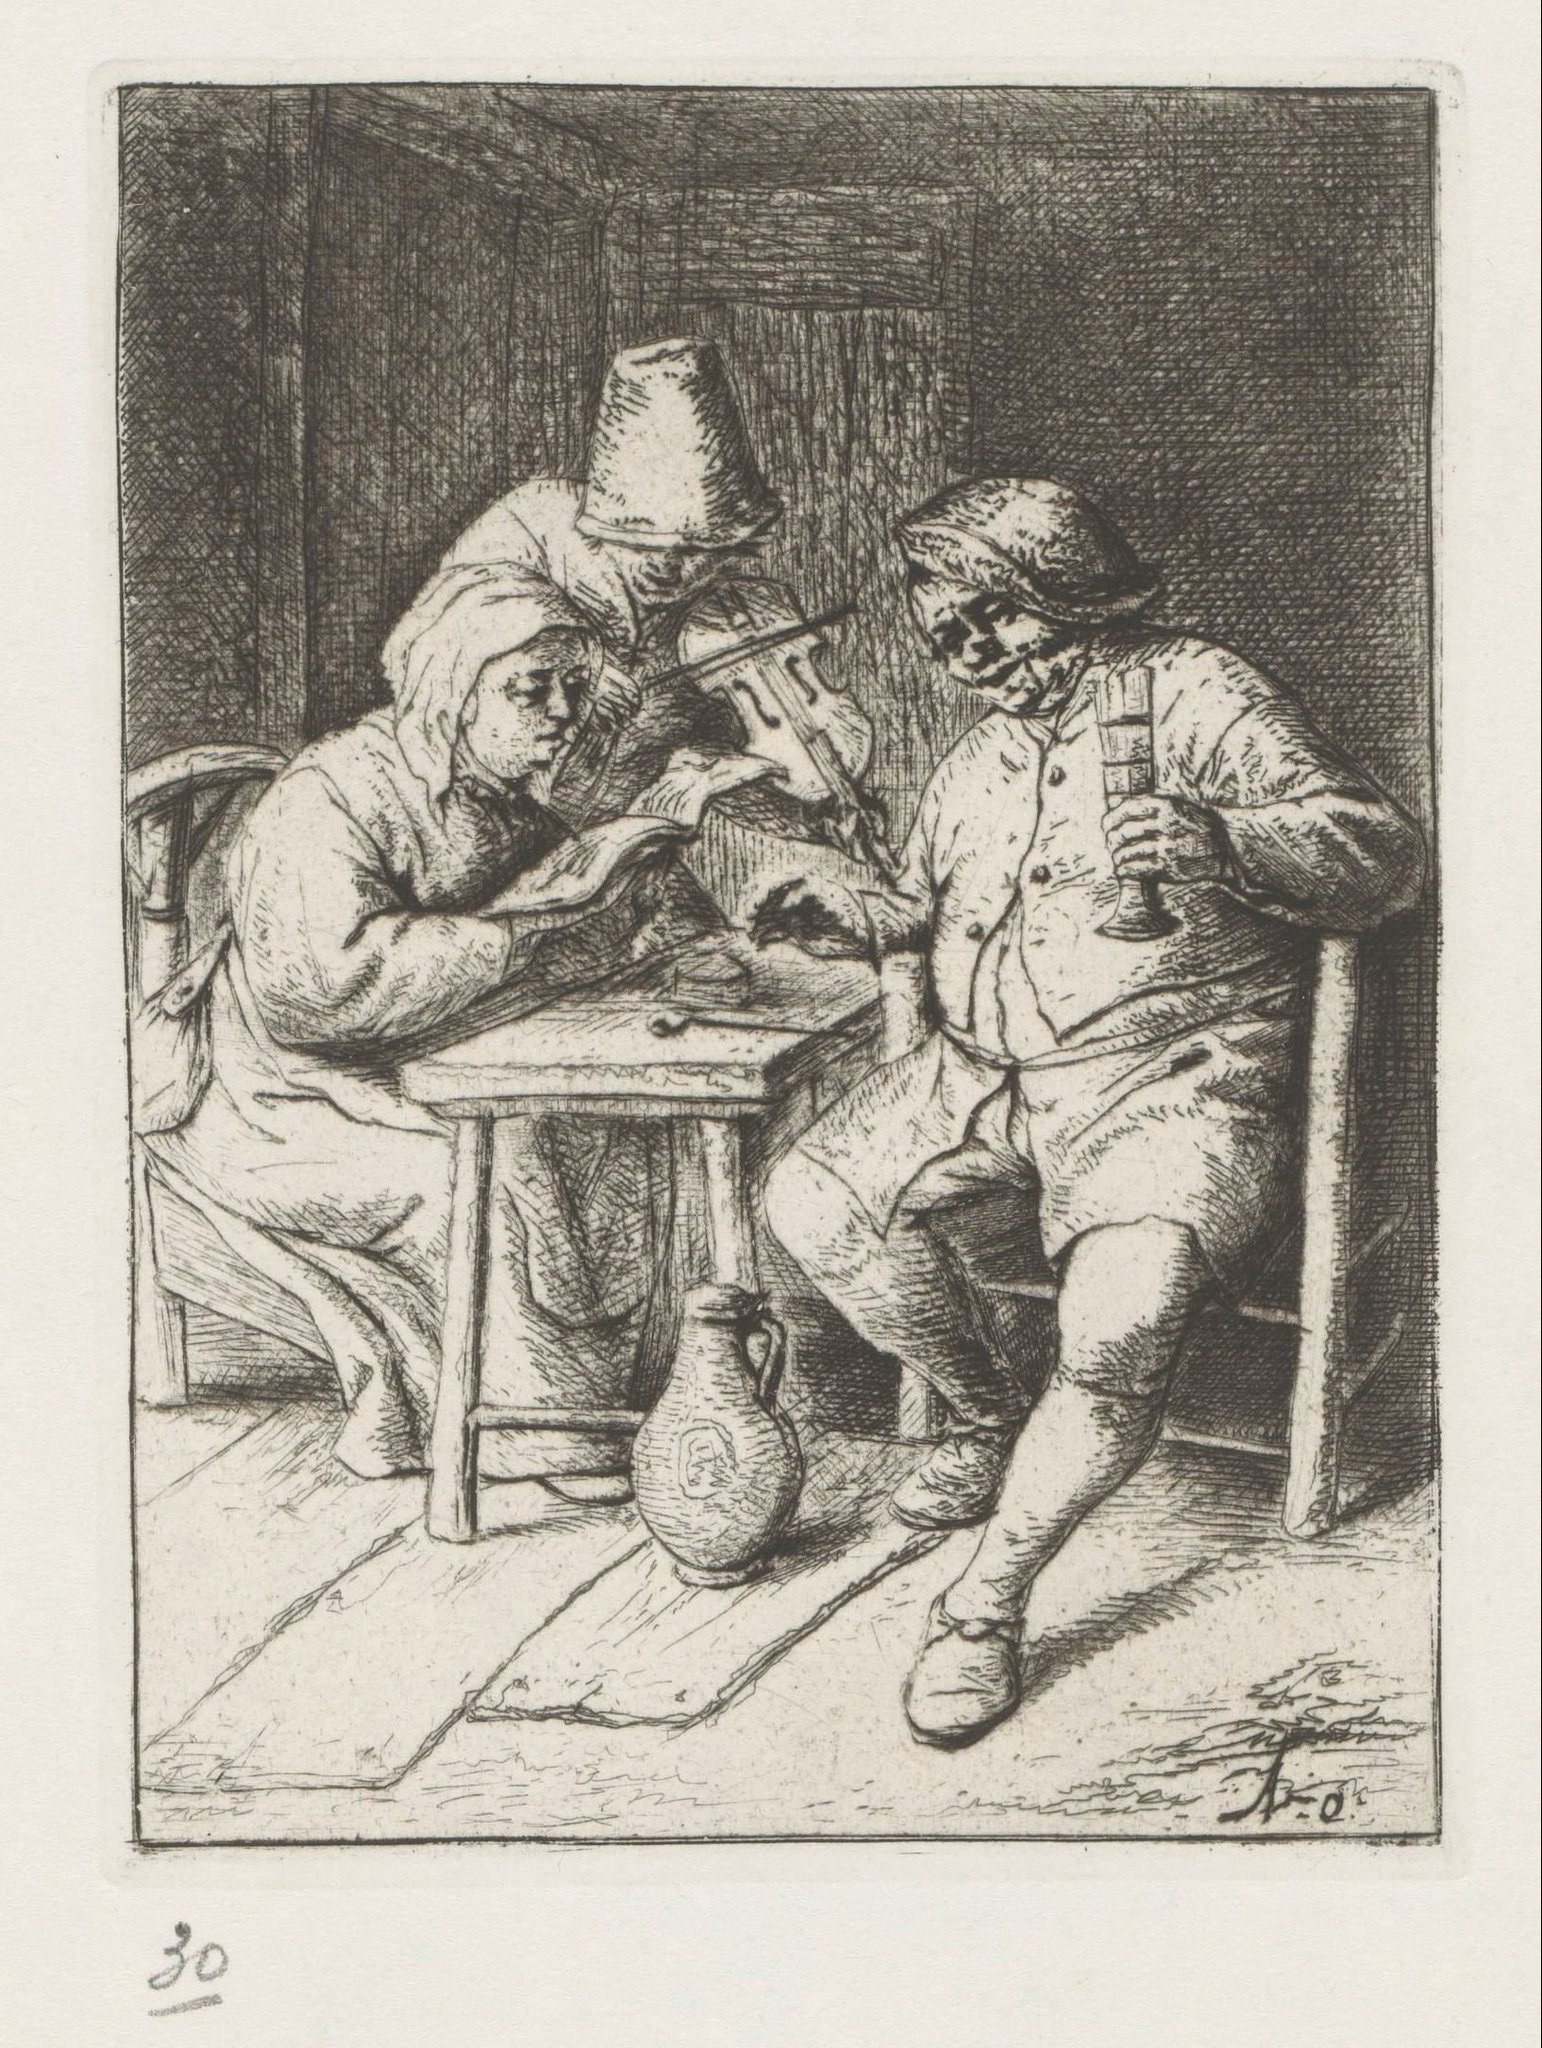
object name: album leaf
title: Vioolspeler en een zingende man en vrouw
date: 1651-1655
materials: paper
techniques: etching, galvanization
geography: haarlem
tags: instrumental and vocal music together, violin, fiddle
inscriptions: collector's mark: ‘RIJKS / MUSM’, collector's mark: ‘B’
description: Een zingende vrouw houdt een boek met muziek vast terwijl naast haar een man op een viool speelt en een andere man met glas in de hand ook vrolijk zingt. De prent maakt deel uit van een portefeuille en is met een andere prent op één albumblad gedrukt.